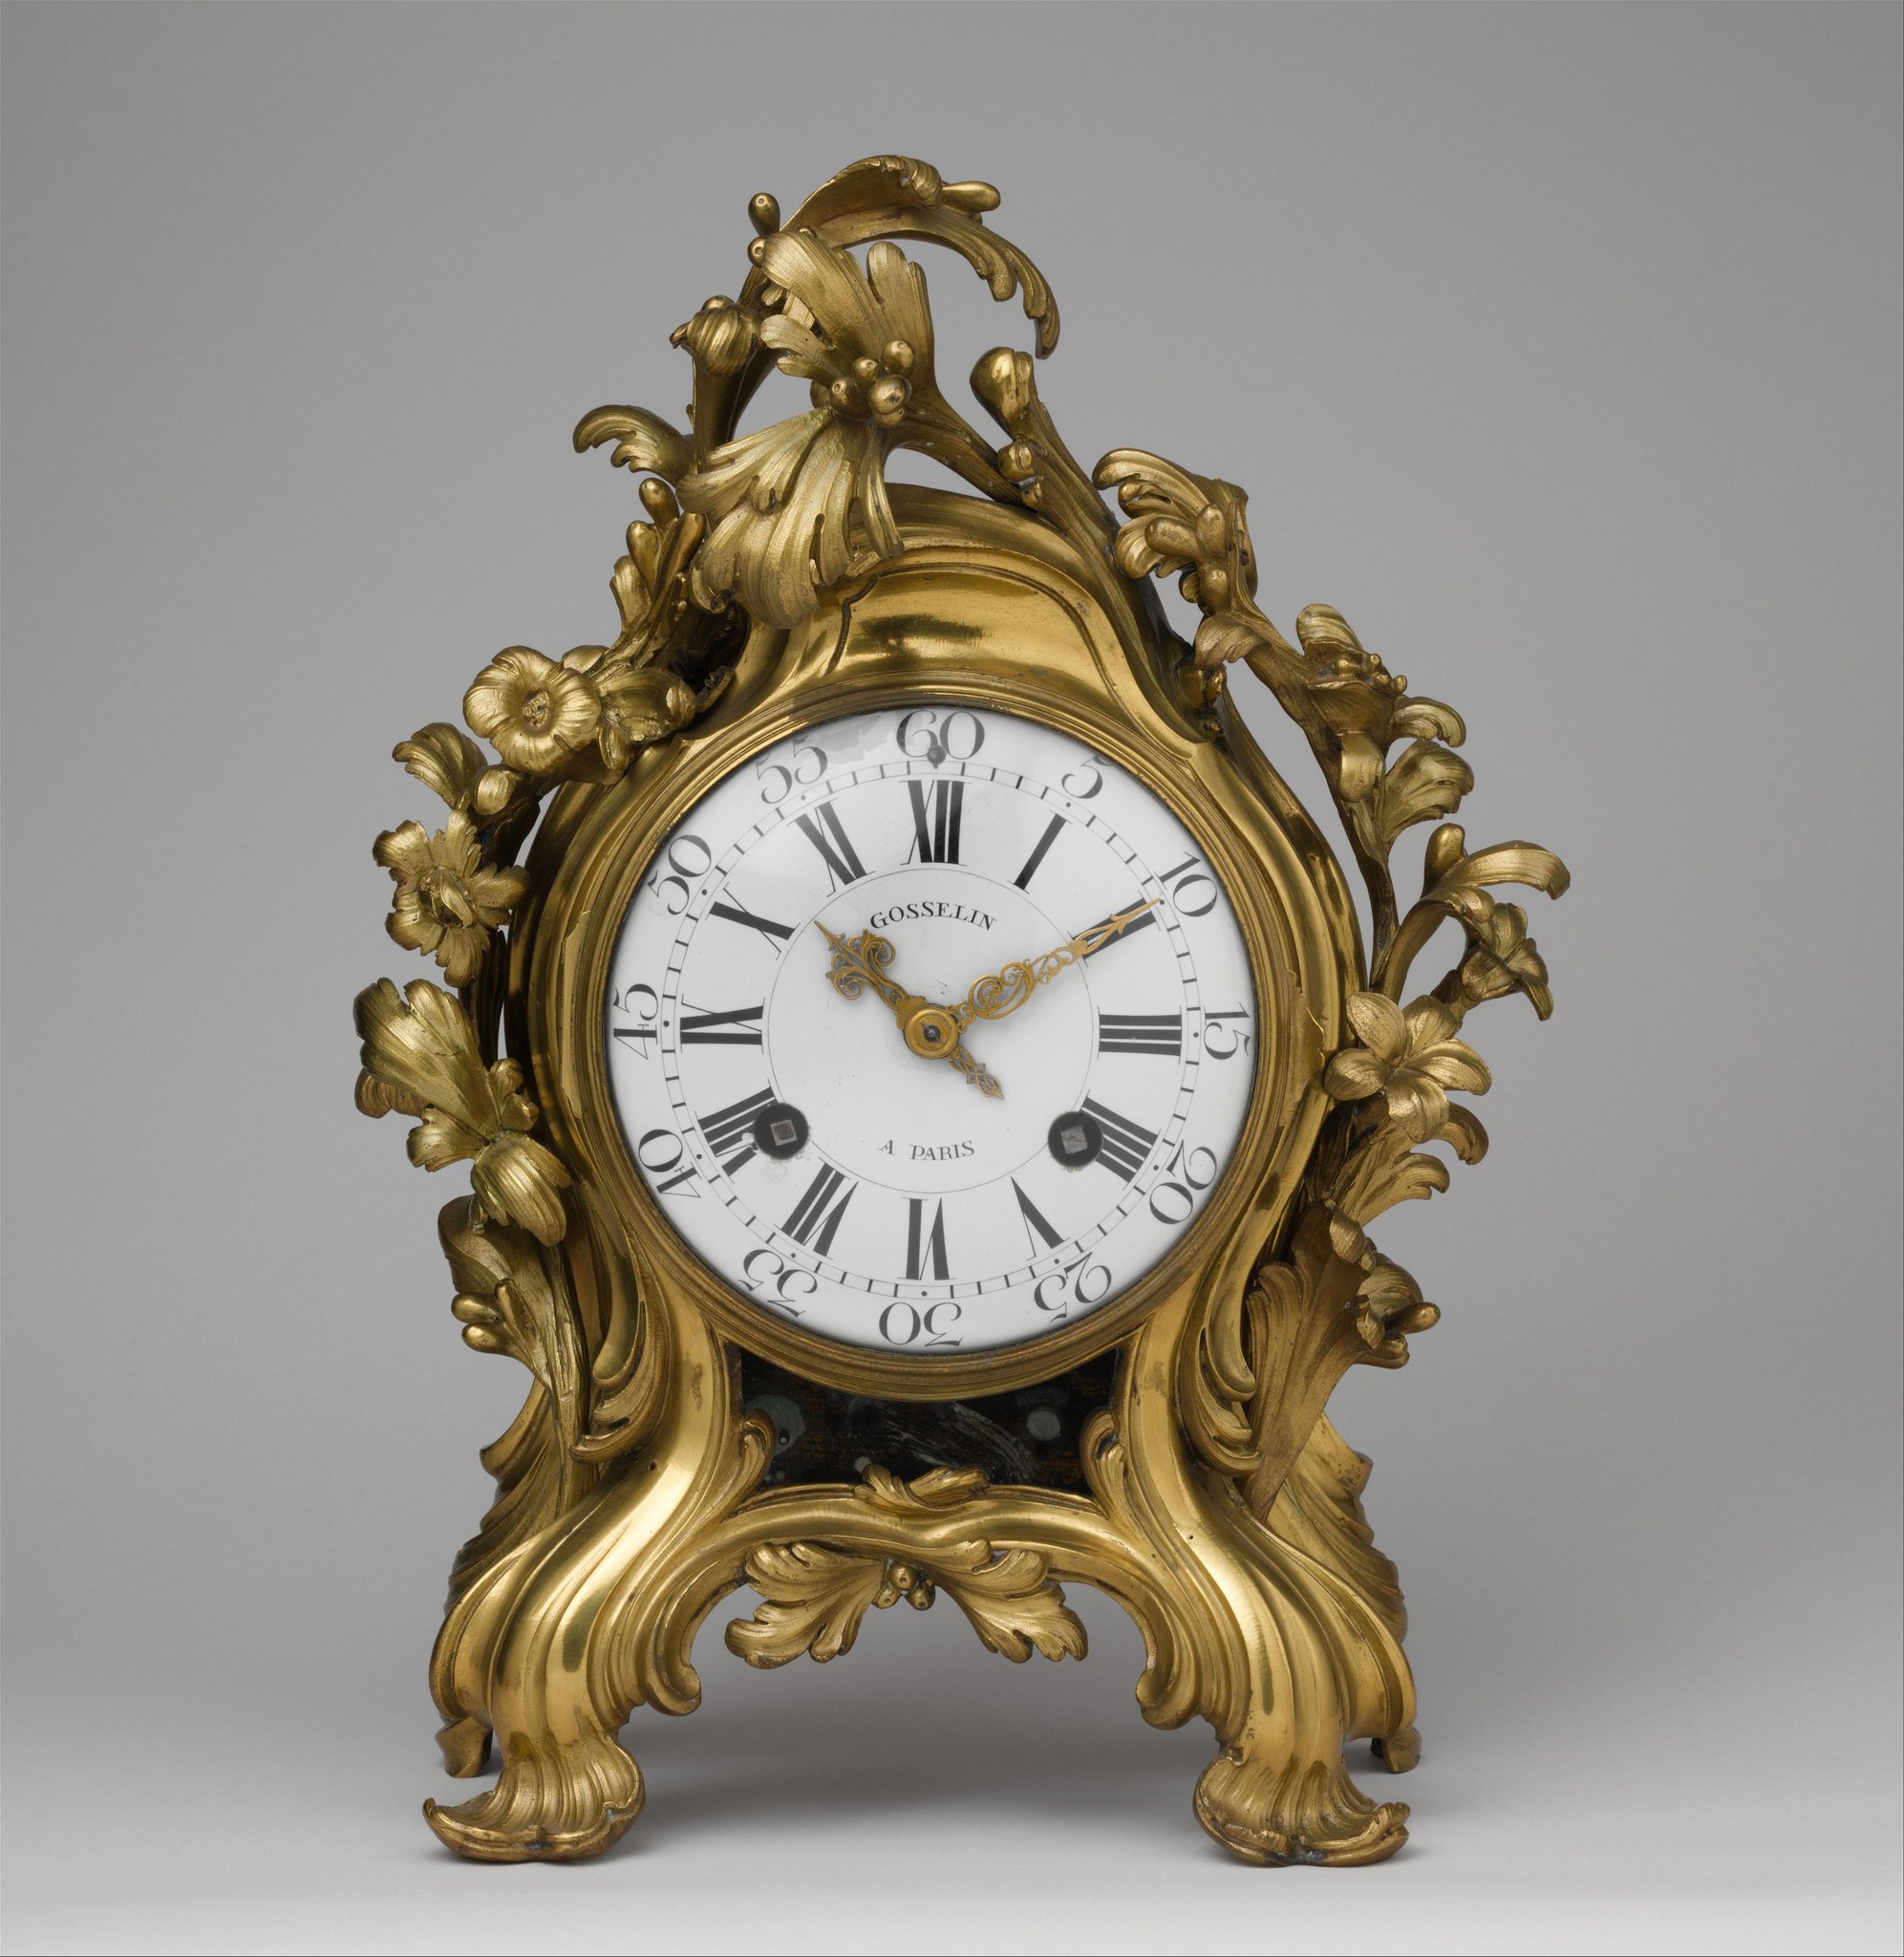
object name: mantel clock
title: Mantel clock (pendule à console)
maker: jean-philippe gosselin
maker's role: maker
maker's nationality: french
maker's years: 1666-1766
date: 1750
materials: brass, bronze, enamel, steel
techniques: gilding, lacquer, silvered